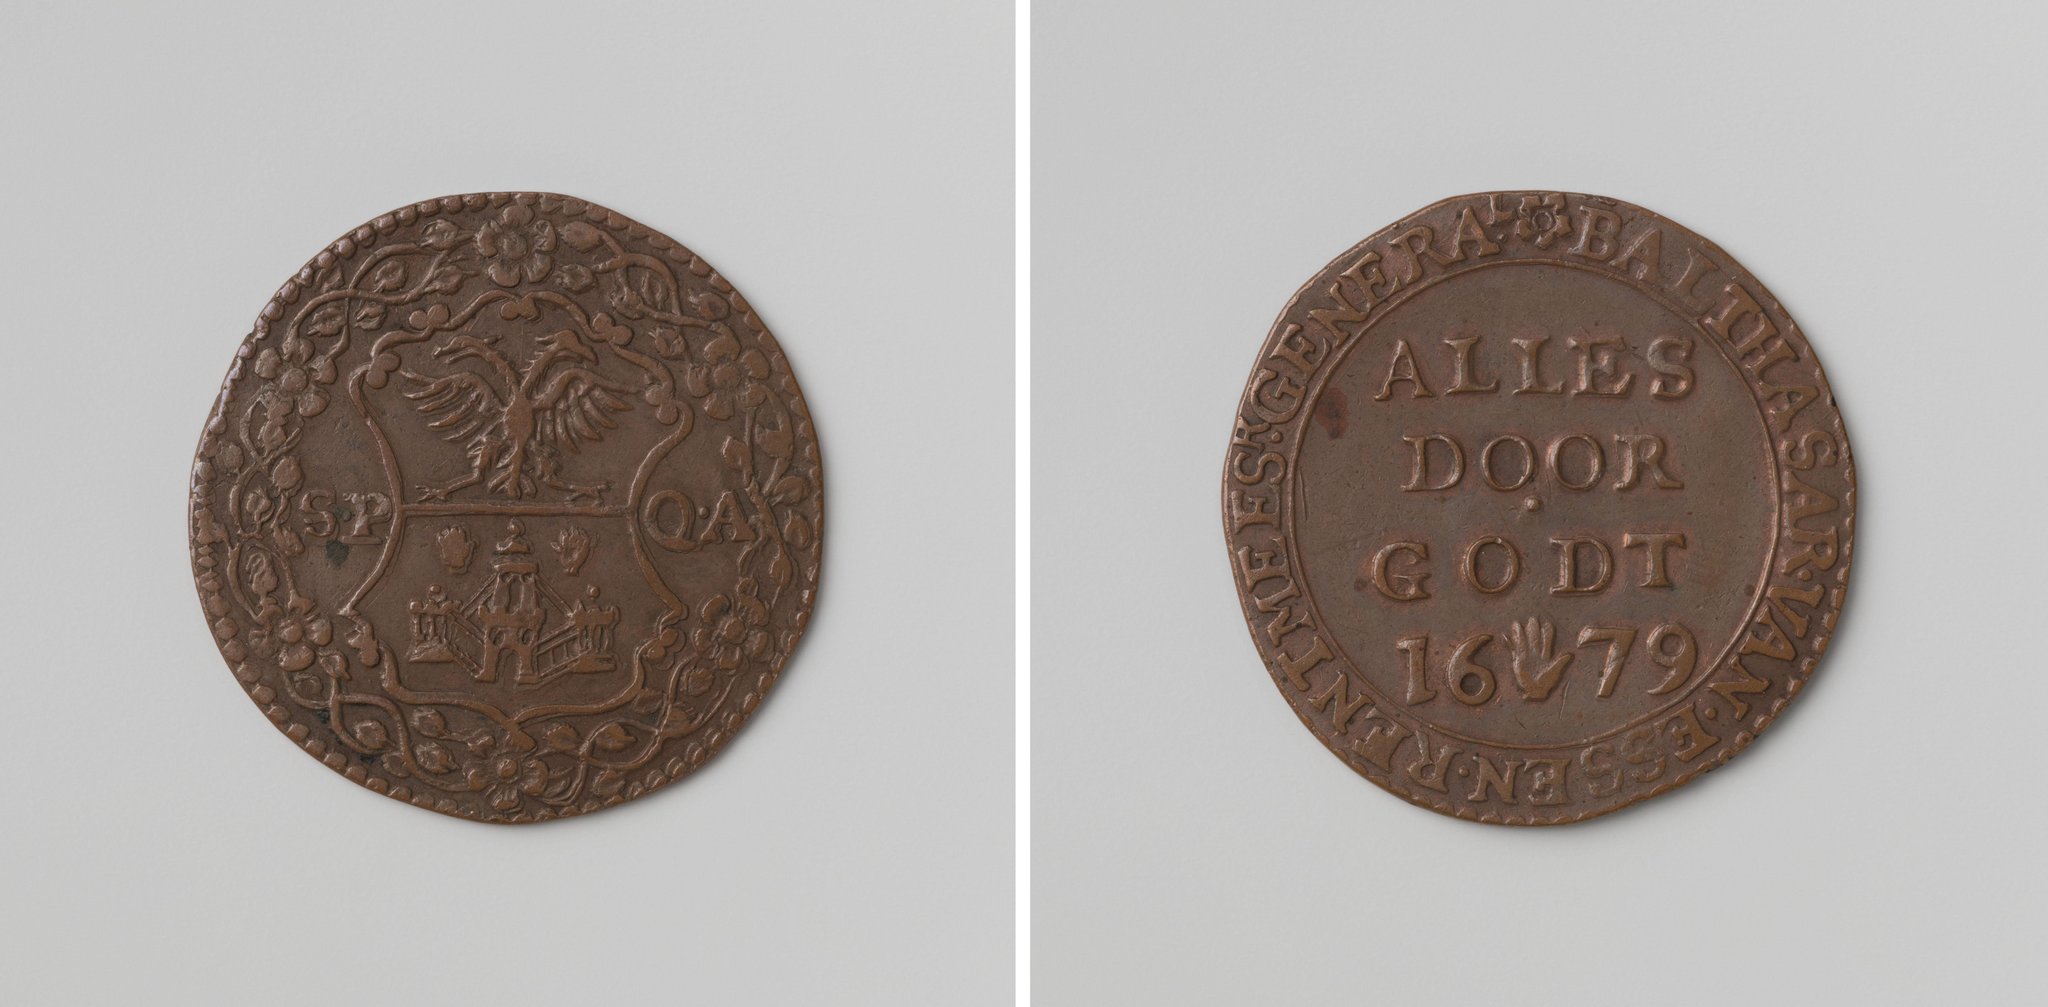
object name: jeton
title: Balthasar van Essen, rentmeester-generaal van de stad Antwerpen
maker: Anonymous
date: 1679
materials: copper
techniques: striking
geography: antwerp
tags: antwerp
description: Koperen penning. Voorzijde: wapenschild in cartouche tussen letters S.P.Q.A. binnen krans van bladeren en bloemen. Keerzijde: opschrift binnen omschrift